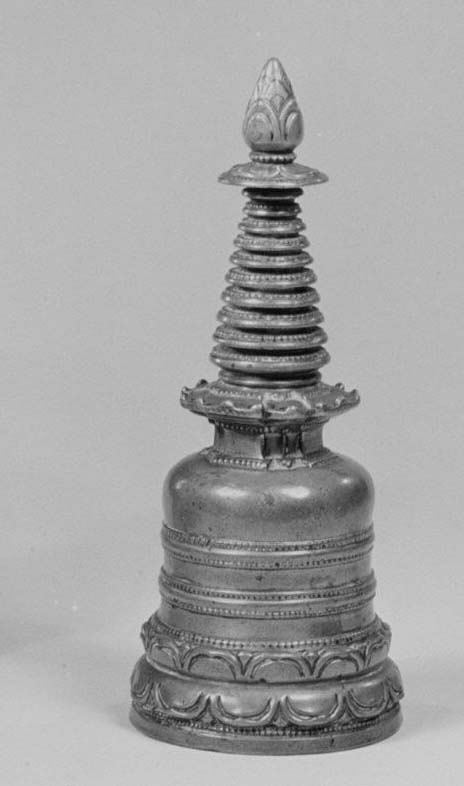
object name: stupa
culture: indian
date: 1001-1200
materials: bronze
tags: stupas